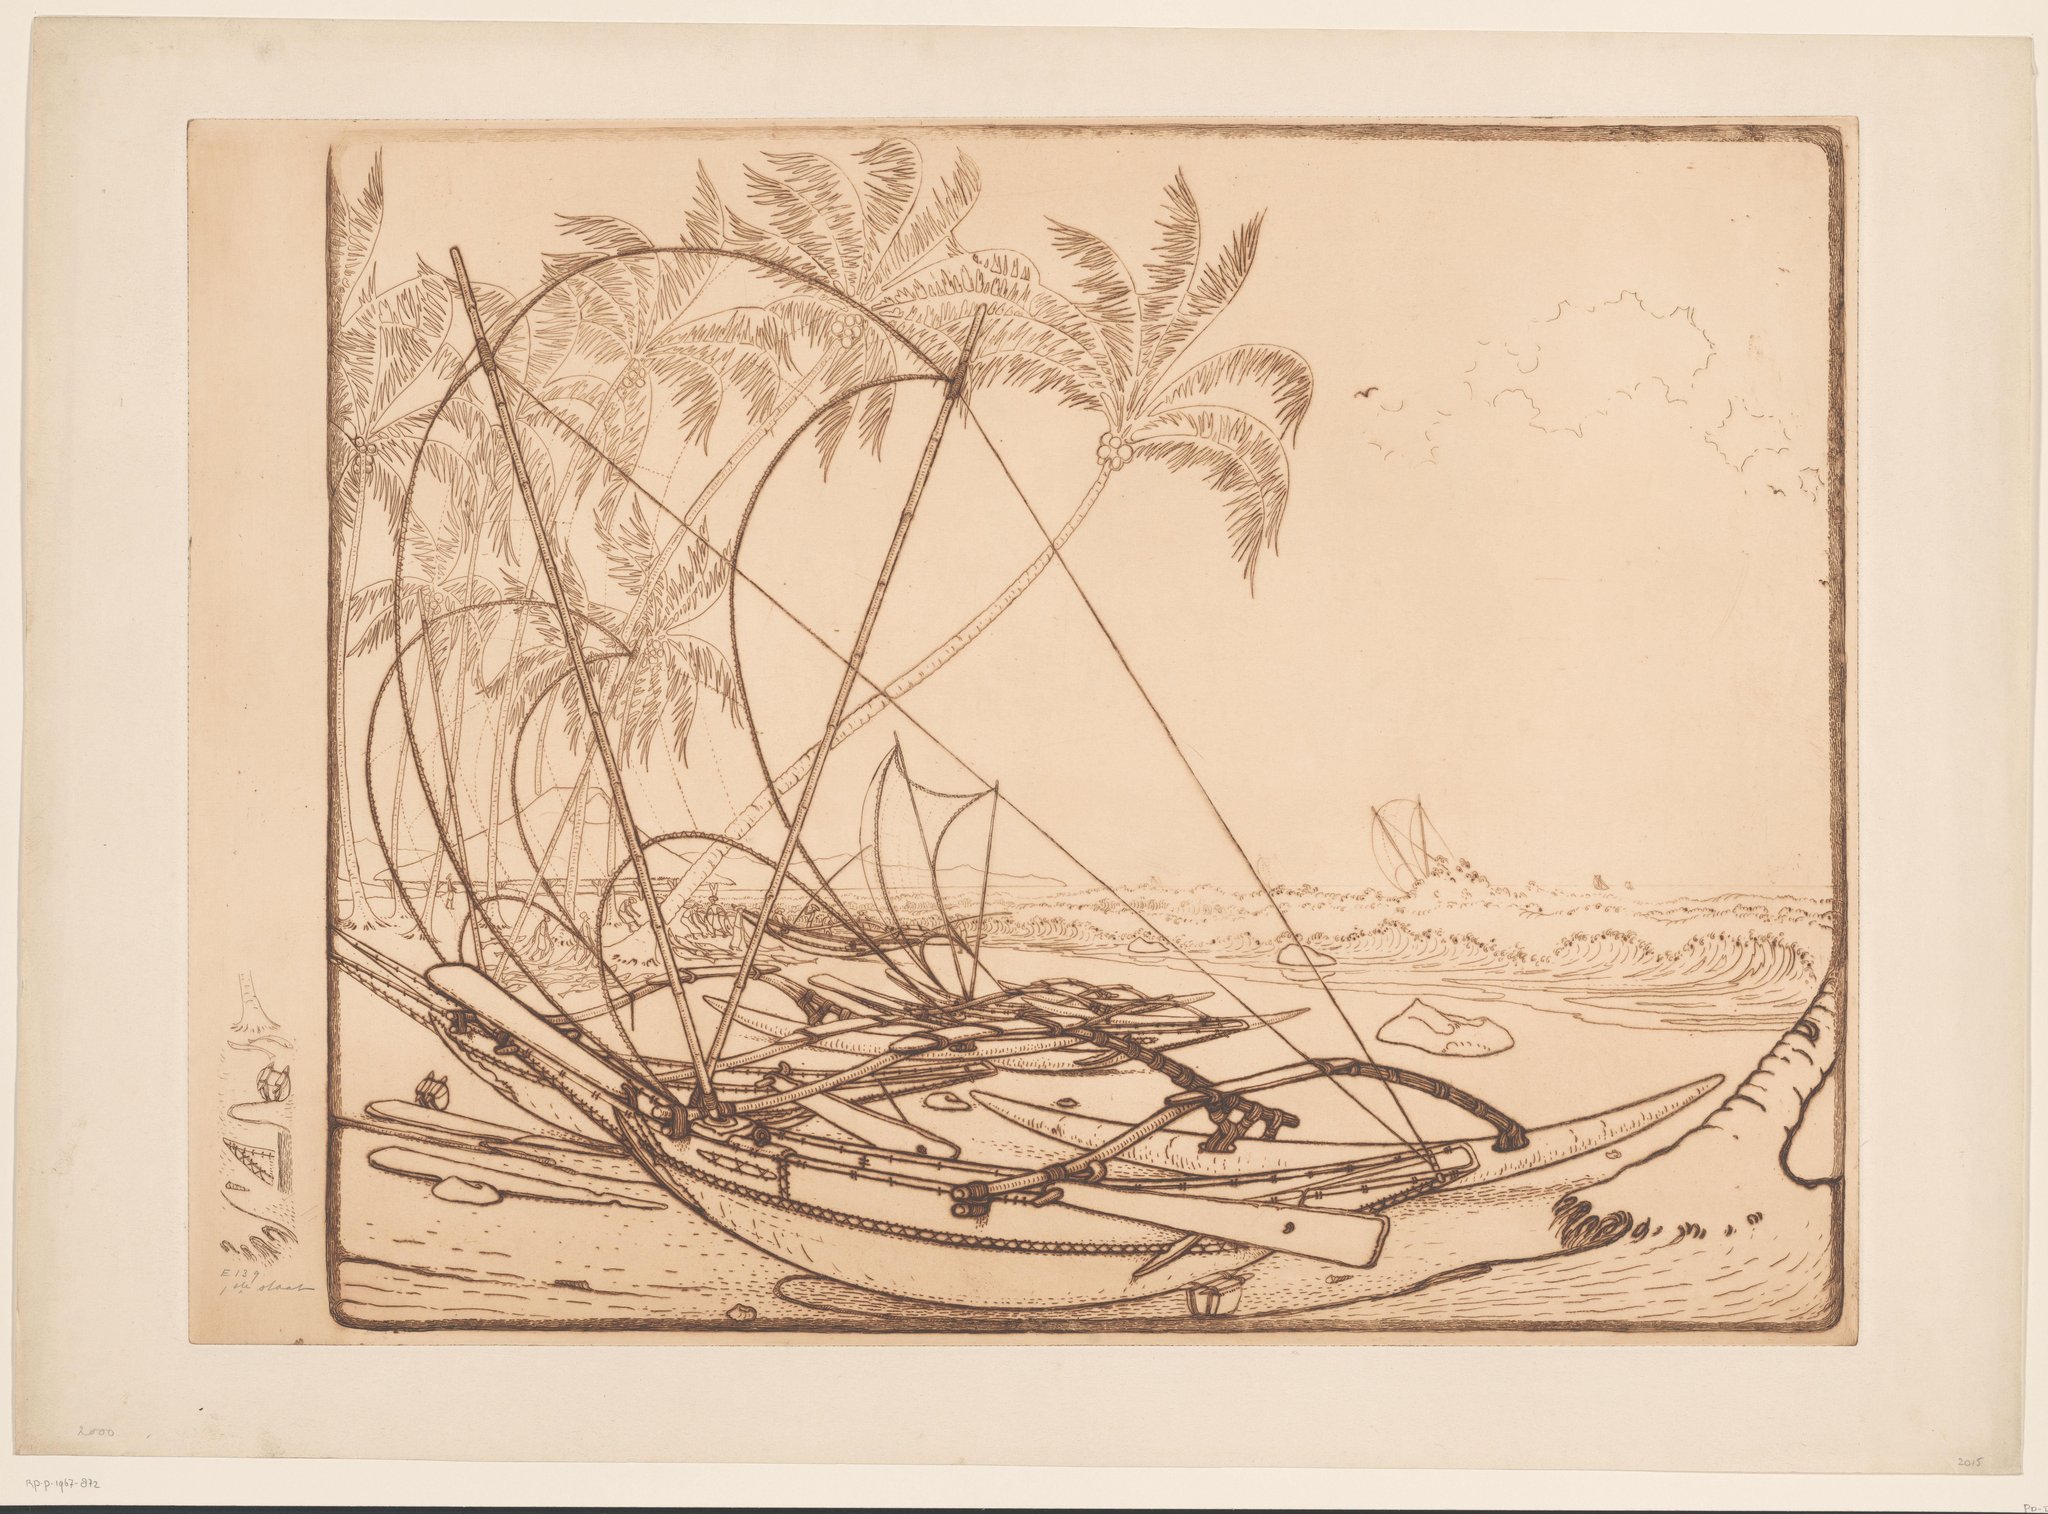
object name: print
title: Zeilen drogen, Colombo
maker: wijnand otto jan nieuwenkamp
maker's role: draughtsman, print maker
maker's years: 1874-1950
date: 1913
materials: paper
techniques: etching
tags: sail, sailing-ship, sailing-boat, ships, boats on land, beached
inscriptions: collector's mark: Lugt 2228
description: Naar schets van 23 januari 1904, gemaakt tijdens ontophoud in Colombo tijdens Nieuwenkamps tweede reis naar Nederlands-Indië.